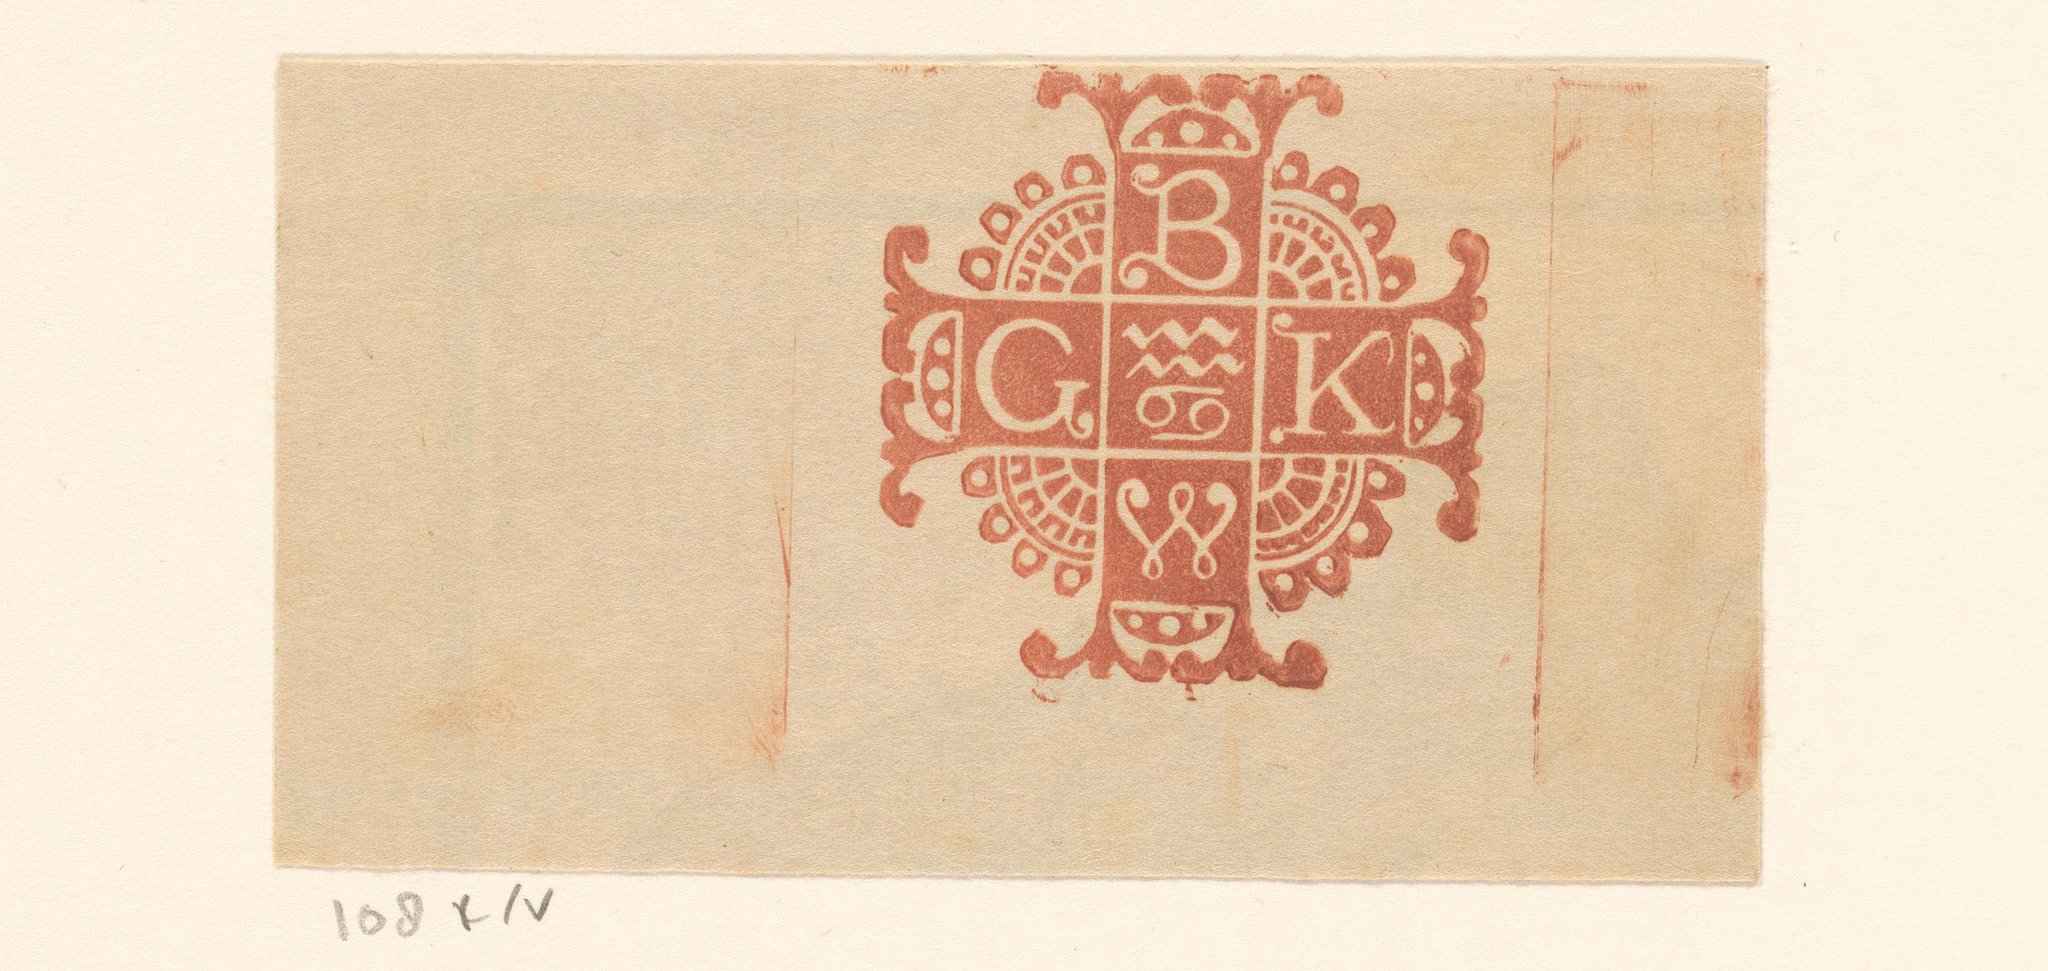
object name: print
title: Vignet met letters B, K, W en G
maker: bernard willem wierink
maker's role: draughtsman, print maker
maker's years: 1856-1939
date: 1871-1939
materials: paper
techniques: relief print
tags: vignette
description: Deze prent is vermoedelijk een plaatsnede, ook al wordt in de literatuur veelal gesproken over een houtsnede. Voor zover Wierink zijn prenten in hoogdruk zelf nader heeft omschreven, heeft hij altijd de term 'plaatsnede' gebruikt.